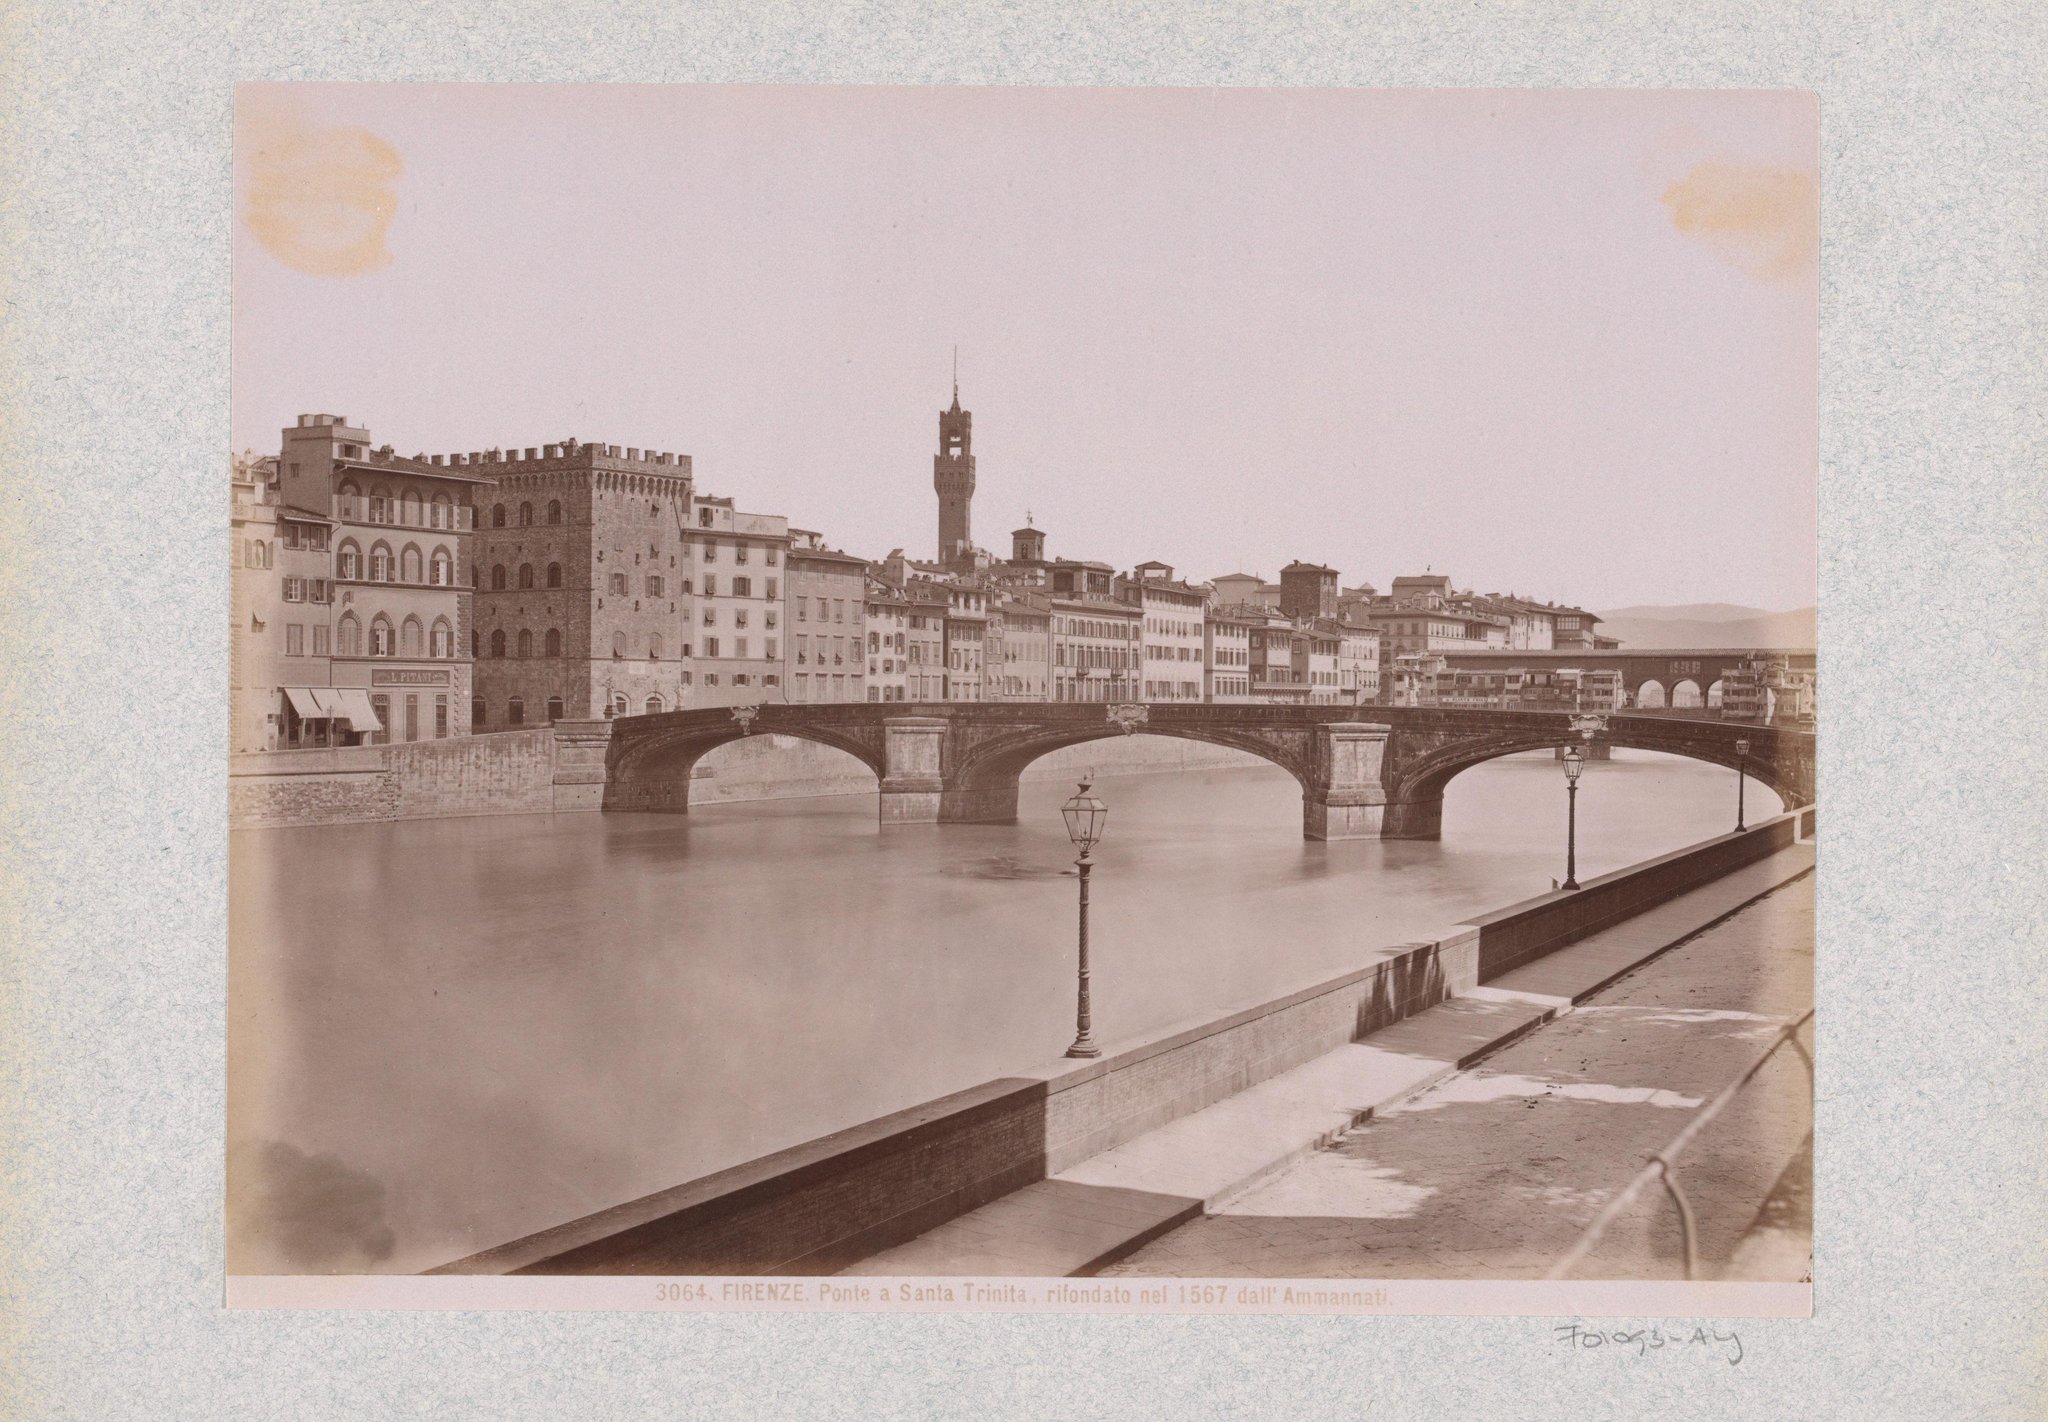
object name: photograph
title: Gezicht op de Ponte a Santa Trinita in Florence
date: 1870-1890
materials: paper, photographic support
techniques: albumen print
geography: florence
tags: bridge, prospect of city, town panorama, silhouette of city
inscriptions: negative number: ‘3064’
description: Onderdeel van Reisalbum met foto's van bezienswaardigheden in Genua, Florence en Venetië.